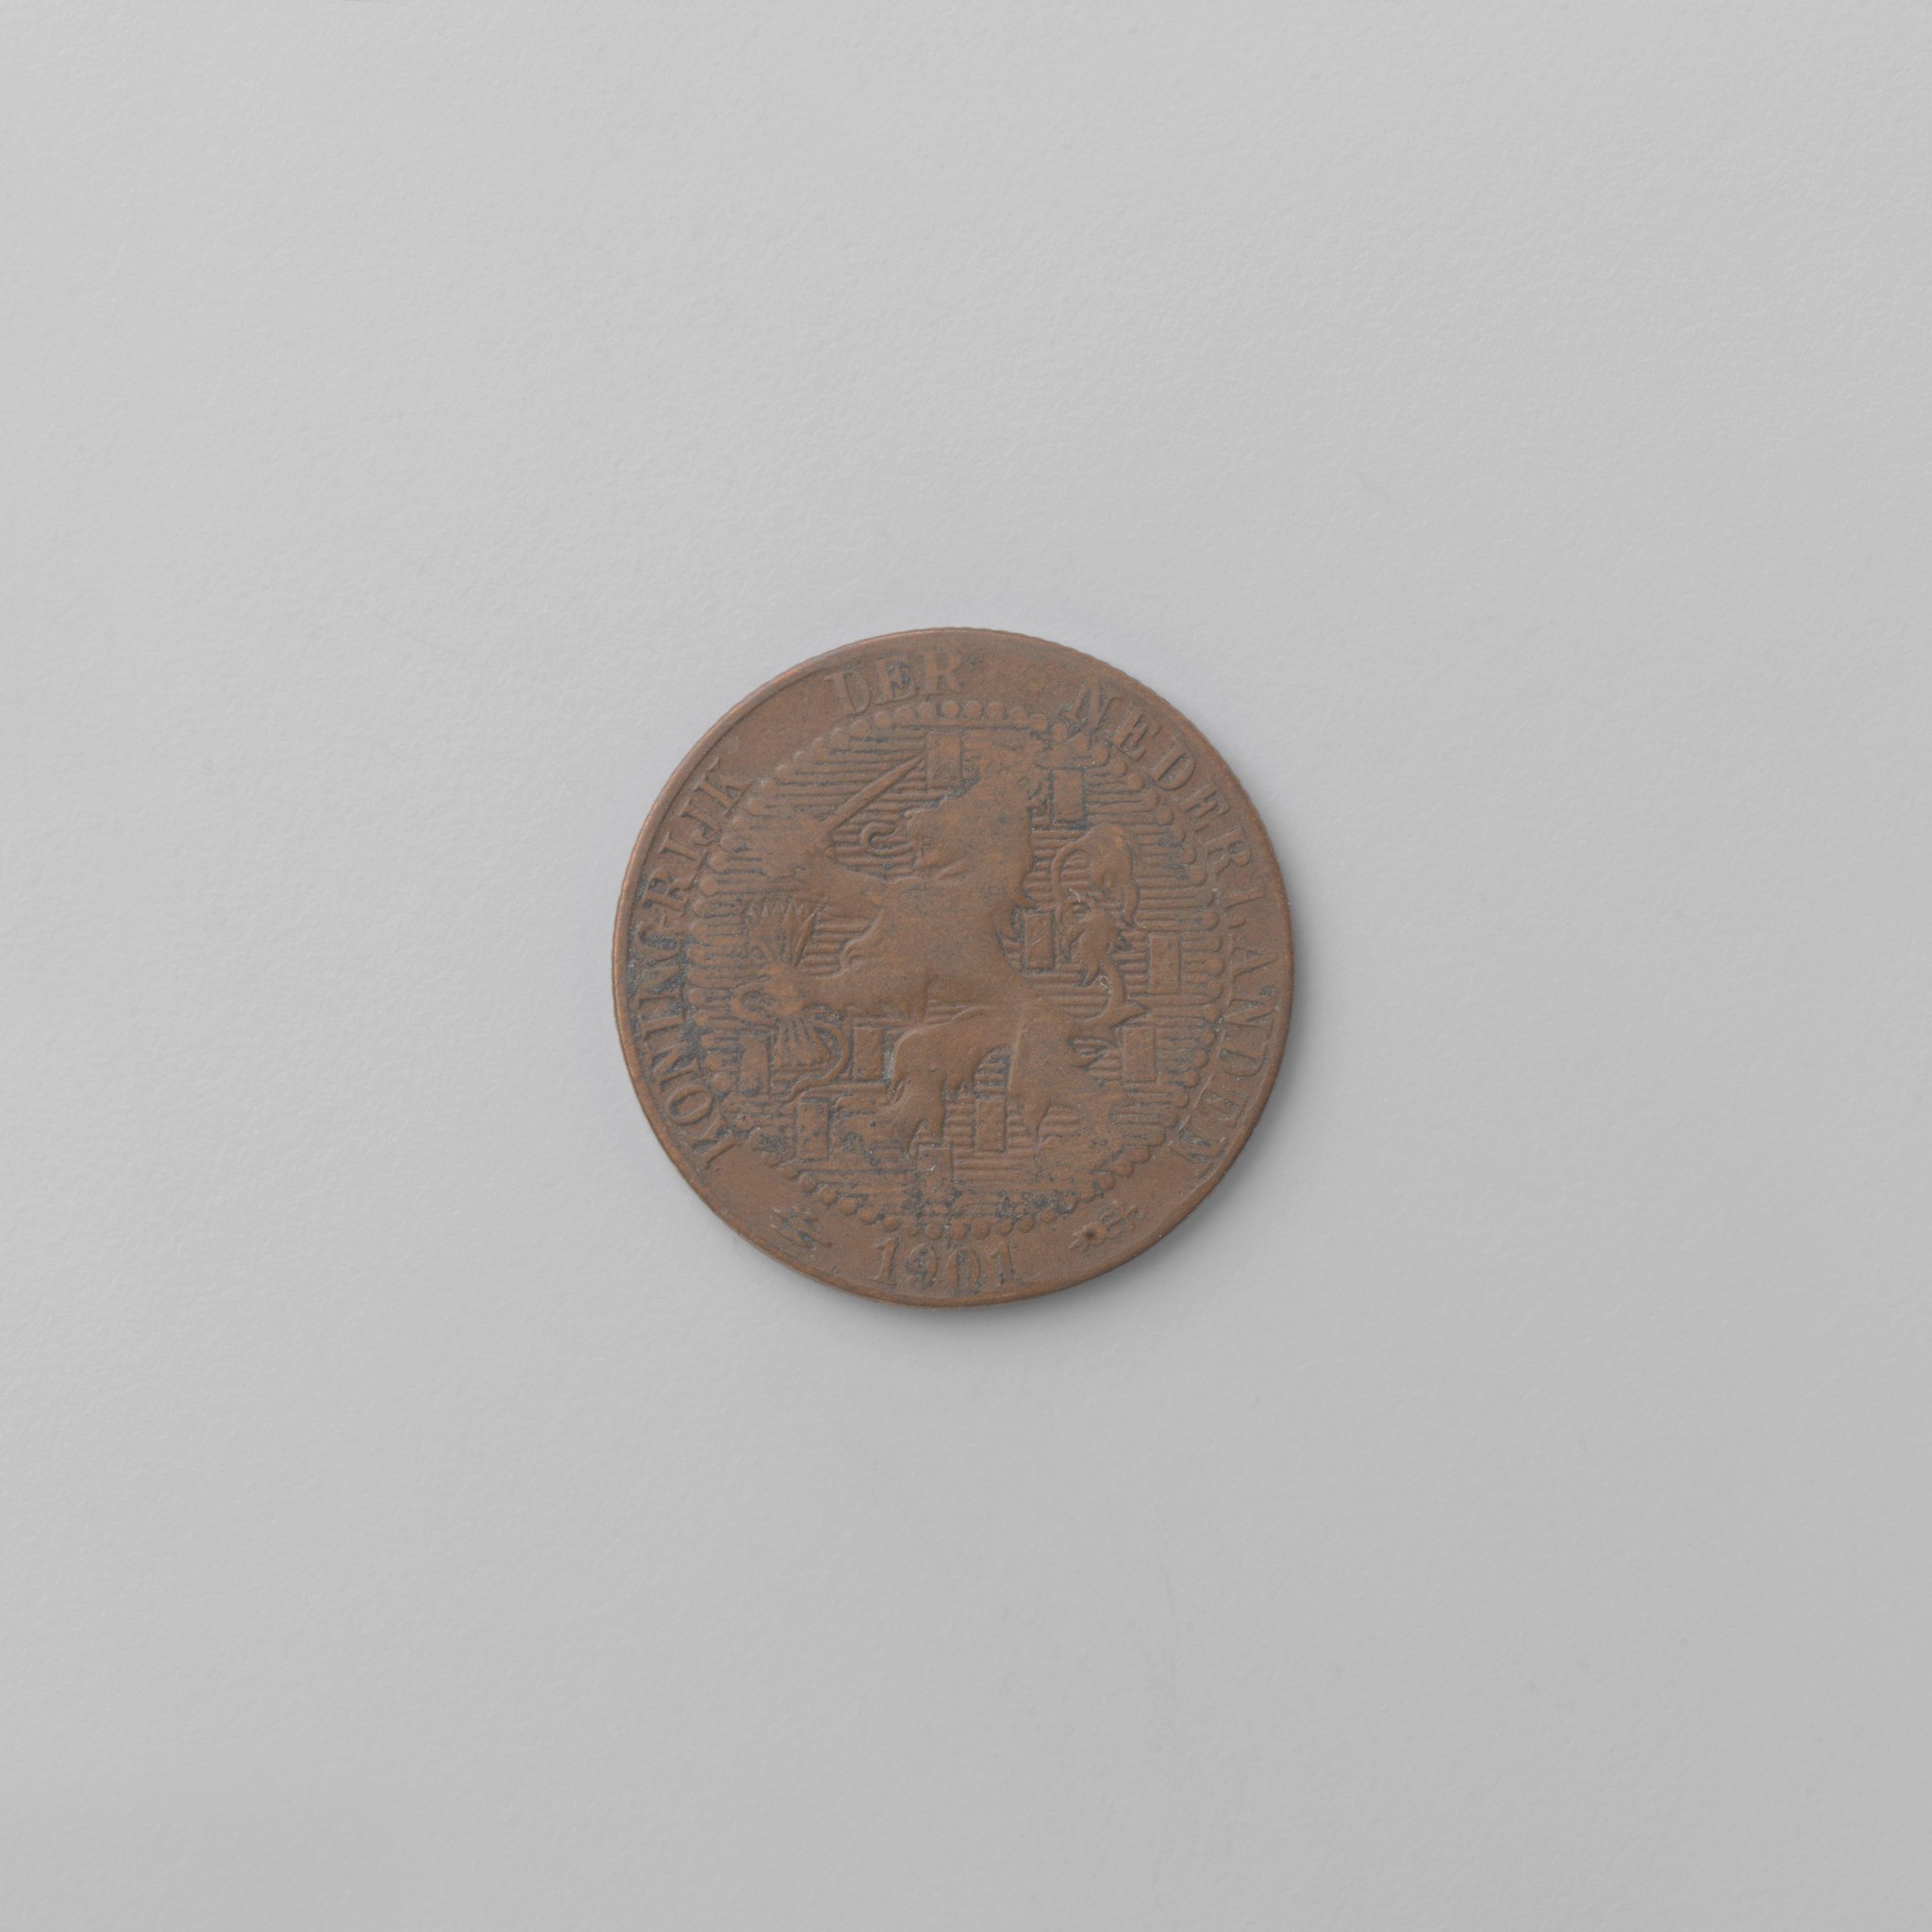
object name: coin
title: Nederlandse cent,1901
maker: wilhelmina of the netherlands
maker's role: print maker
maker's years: 1880-1962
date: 1901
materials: bronze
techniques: striking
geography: utrecht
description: Bronzen munt. Voorzijde: in een veld rijkswapen. Jaartal onderaan in omschrift. Keerzijde: binnen twee samengebonden oranjetakken waarde-aanduiding 1 cent. Kartelrand.